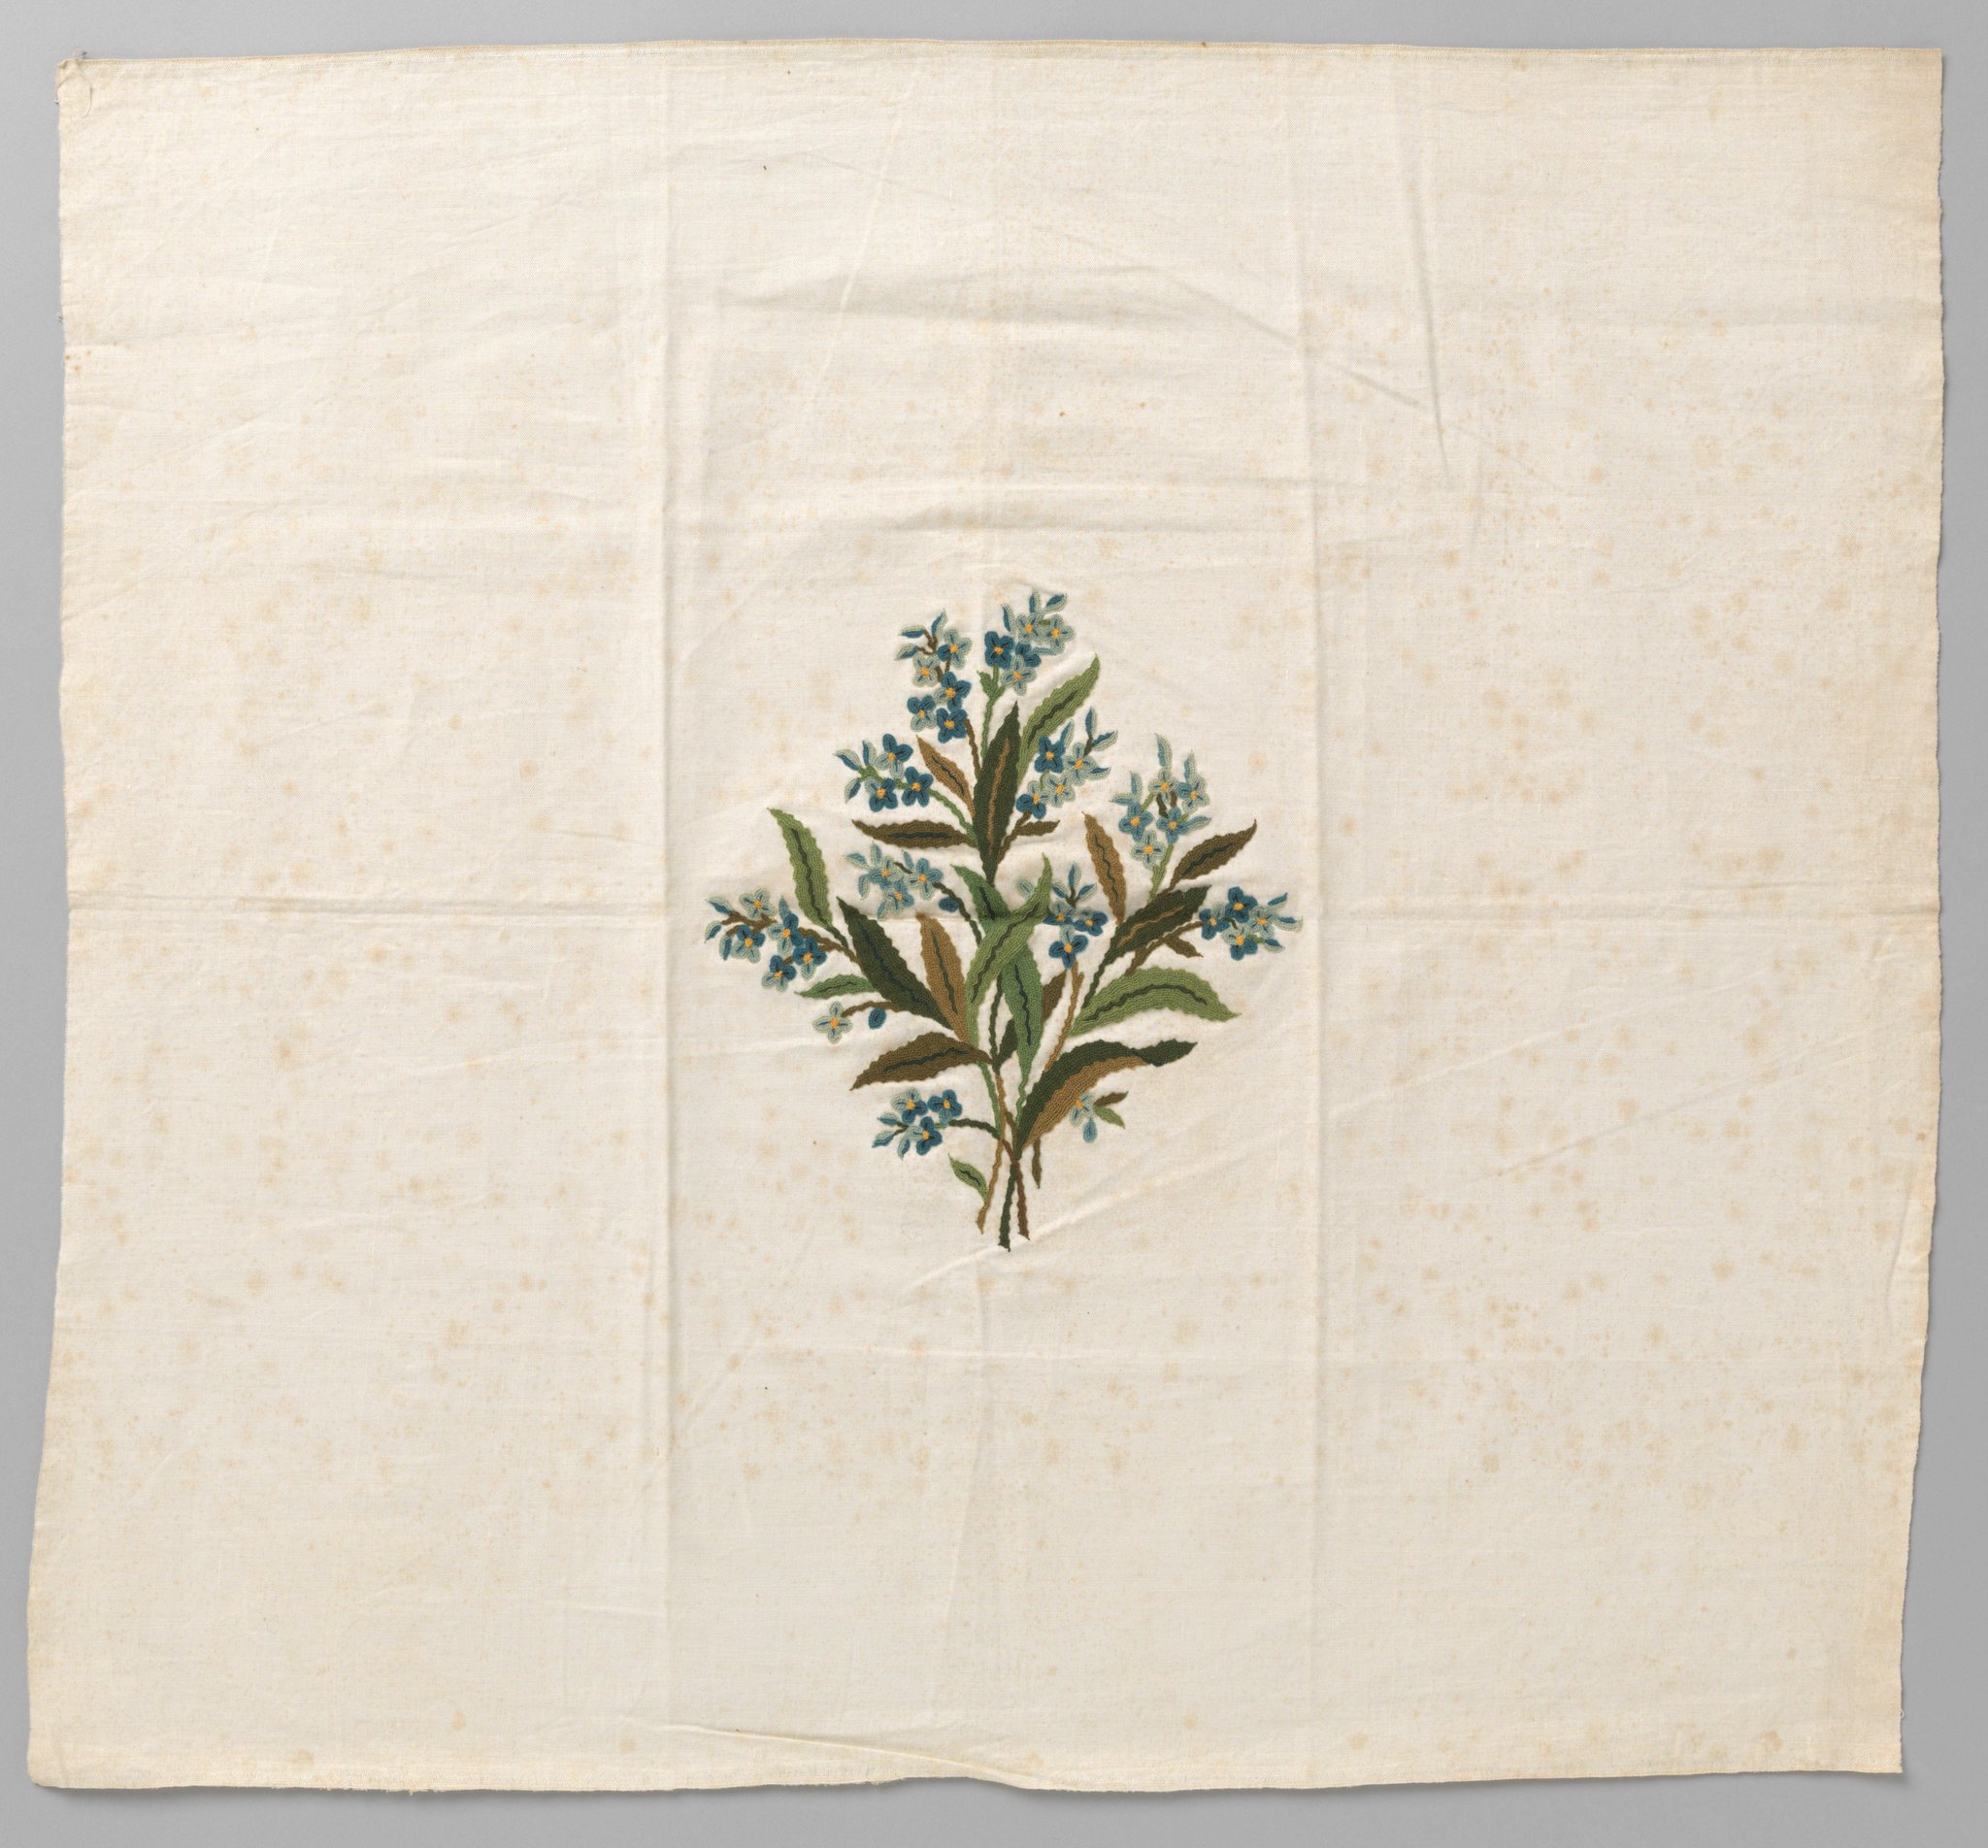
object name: bekledingsstof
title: Metrage bekledingsstof met borduurwerk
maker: Anonymous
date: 1850-1949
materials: cotton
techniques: weave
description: Metrage bekledingsstof, met een bloemboeket vergeetmenietjes.